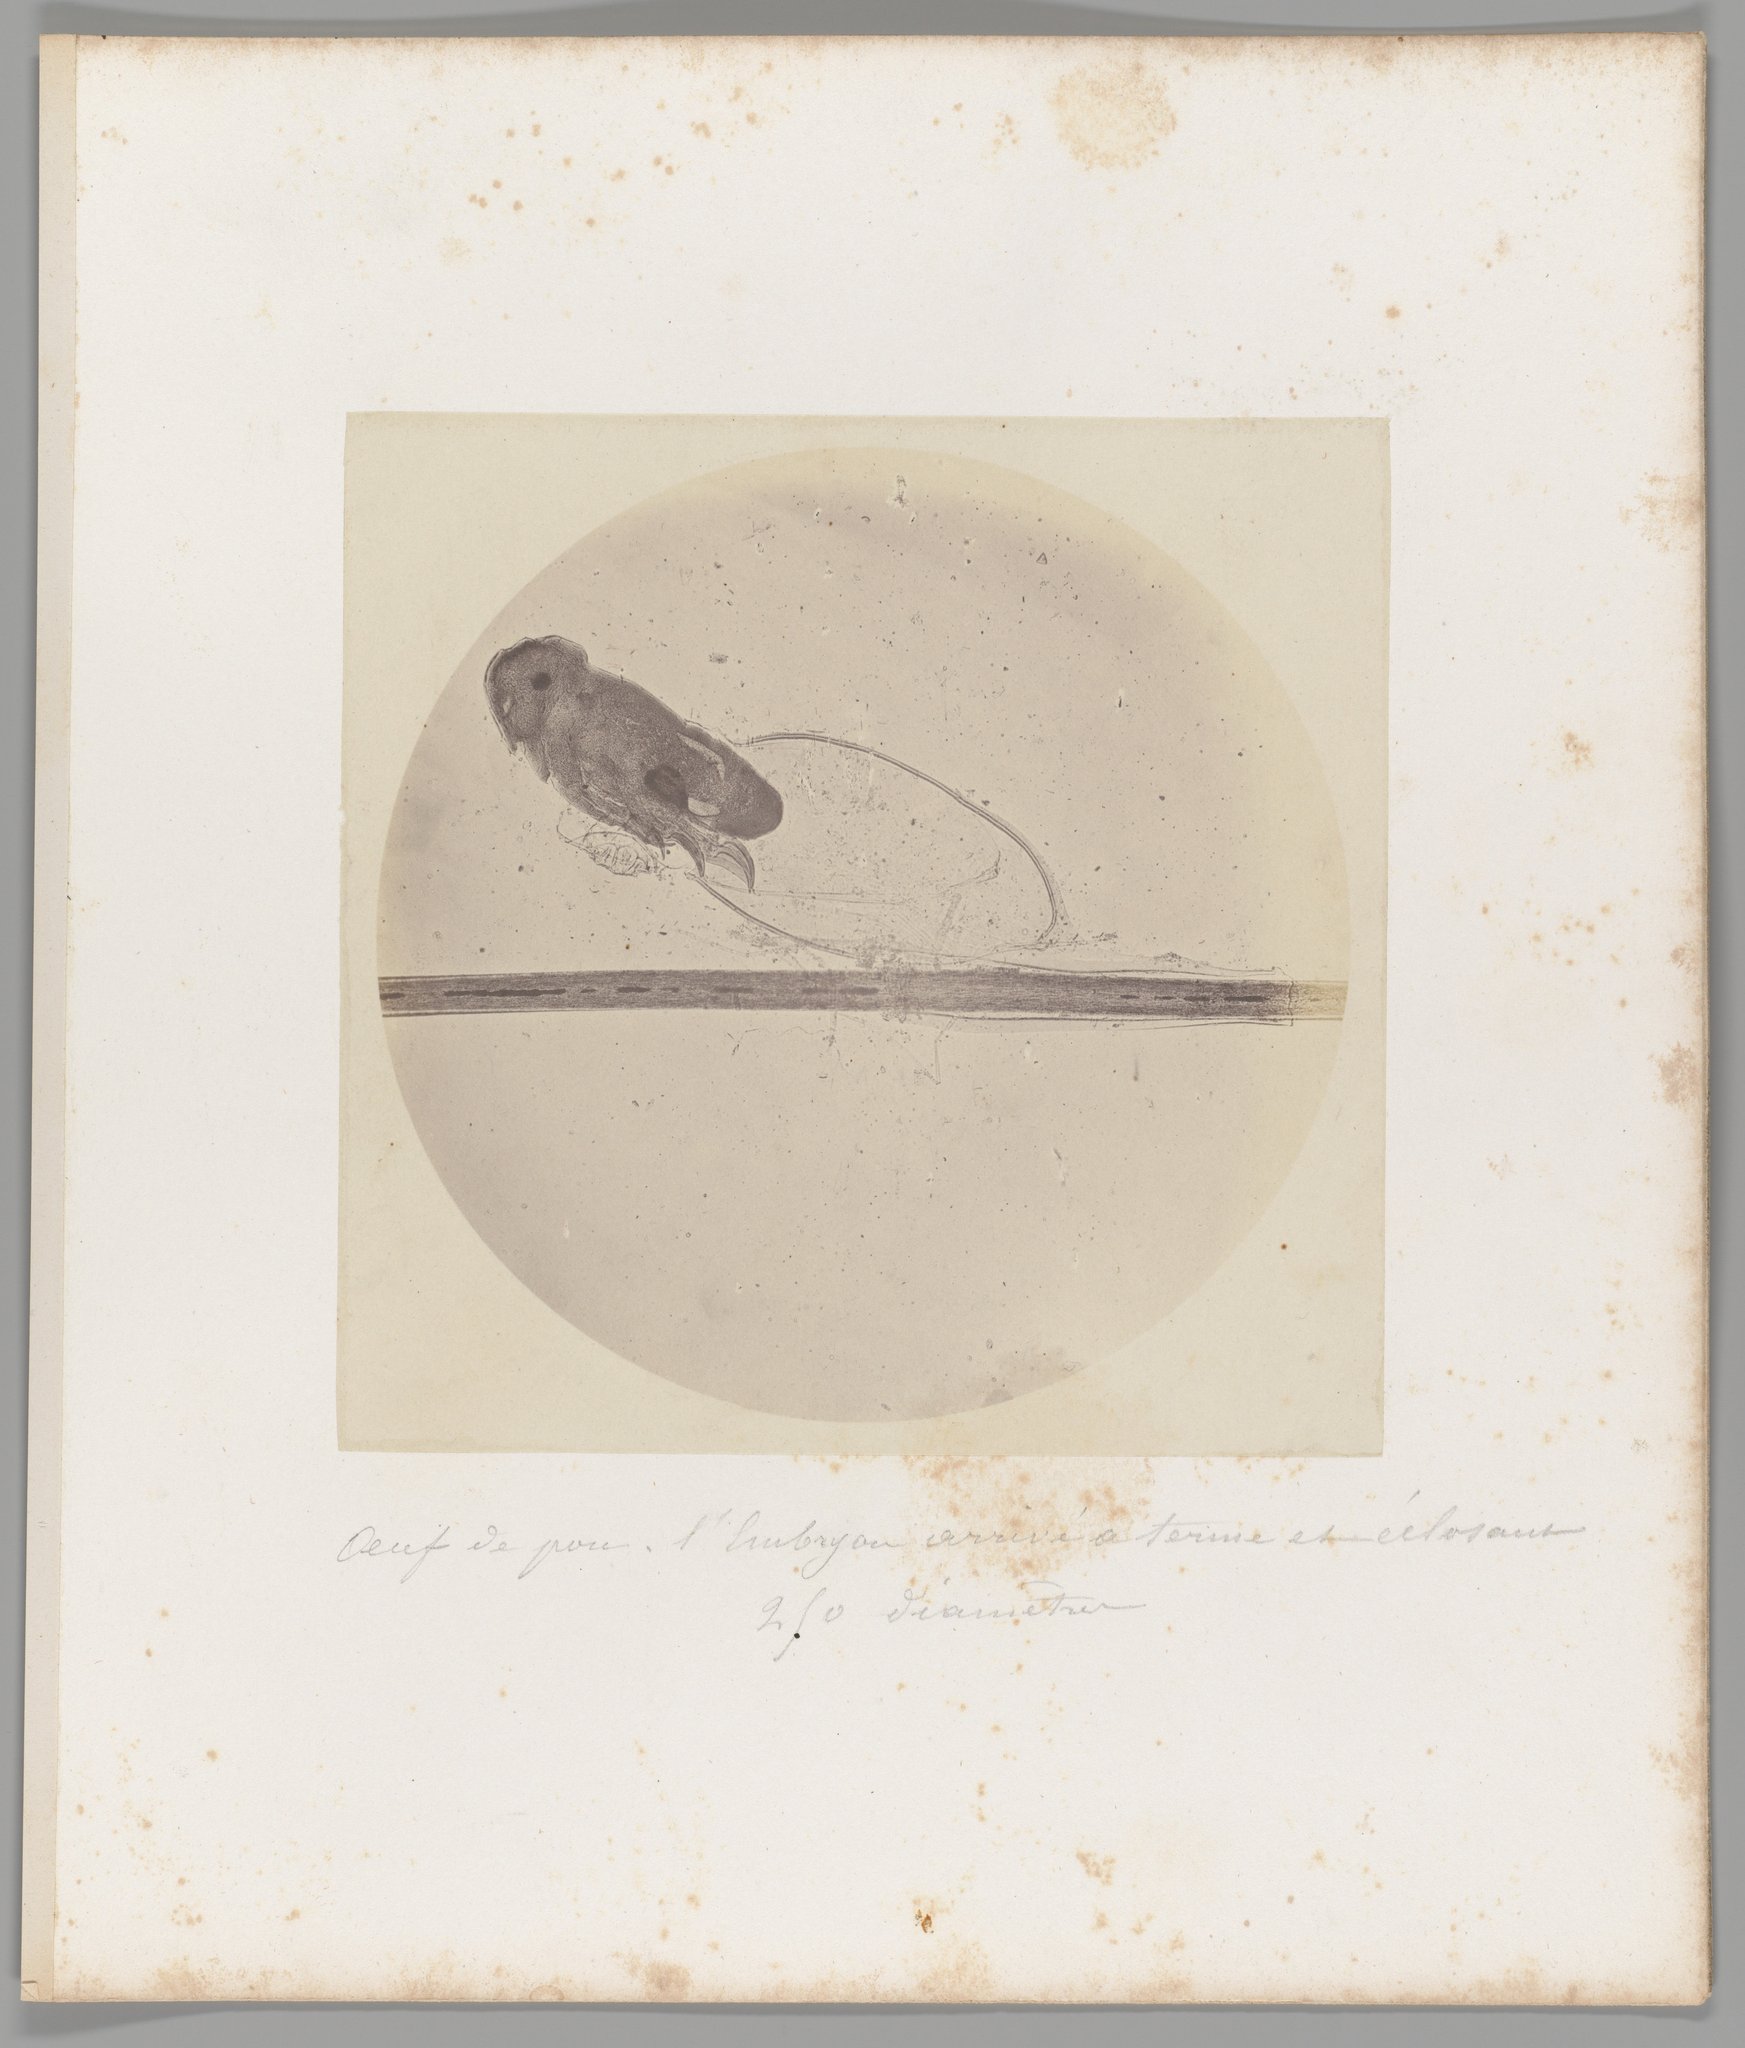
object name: photograph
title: [Untitled]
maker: auguste-adolphe bertsch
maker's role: artist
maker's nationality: french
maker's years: 1813-1871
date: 1853-1857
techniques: salted paper print